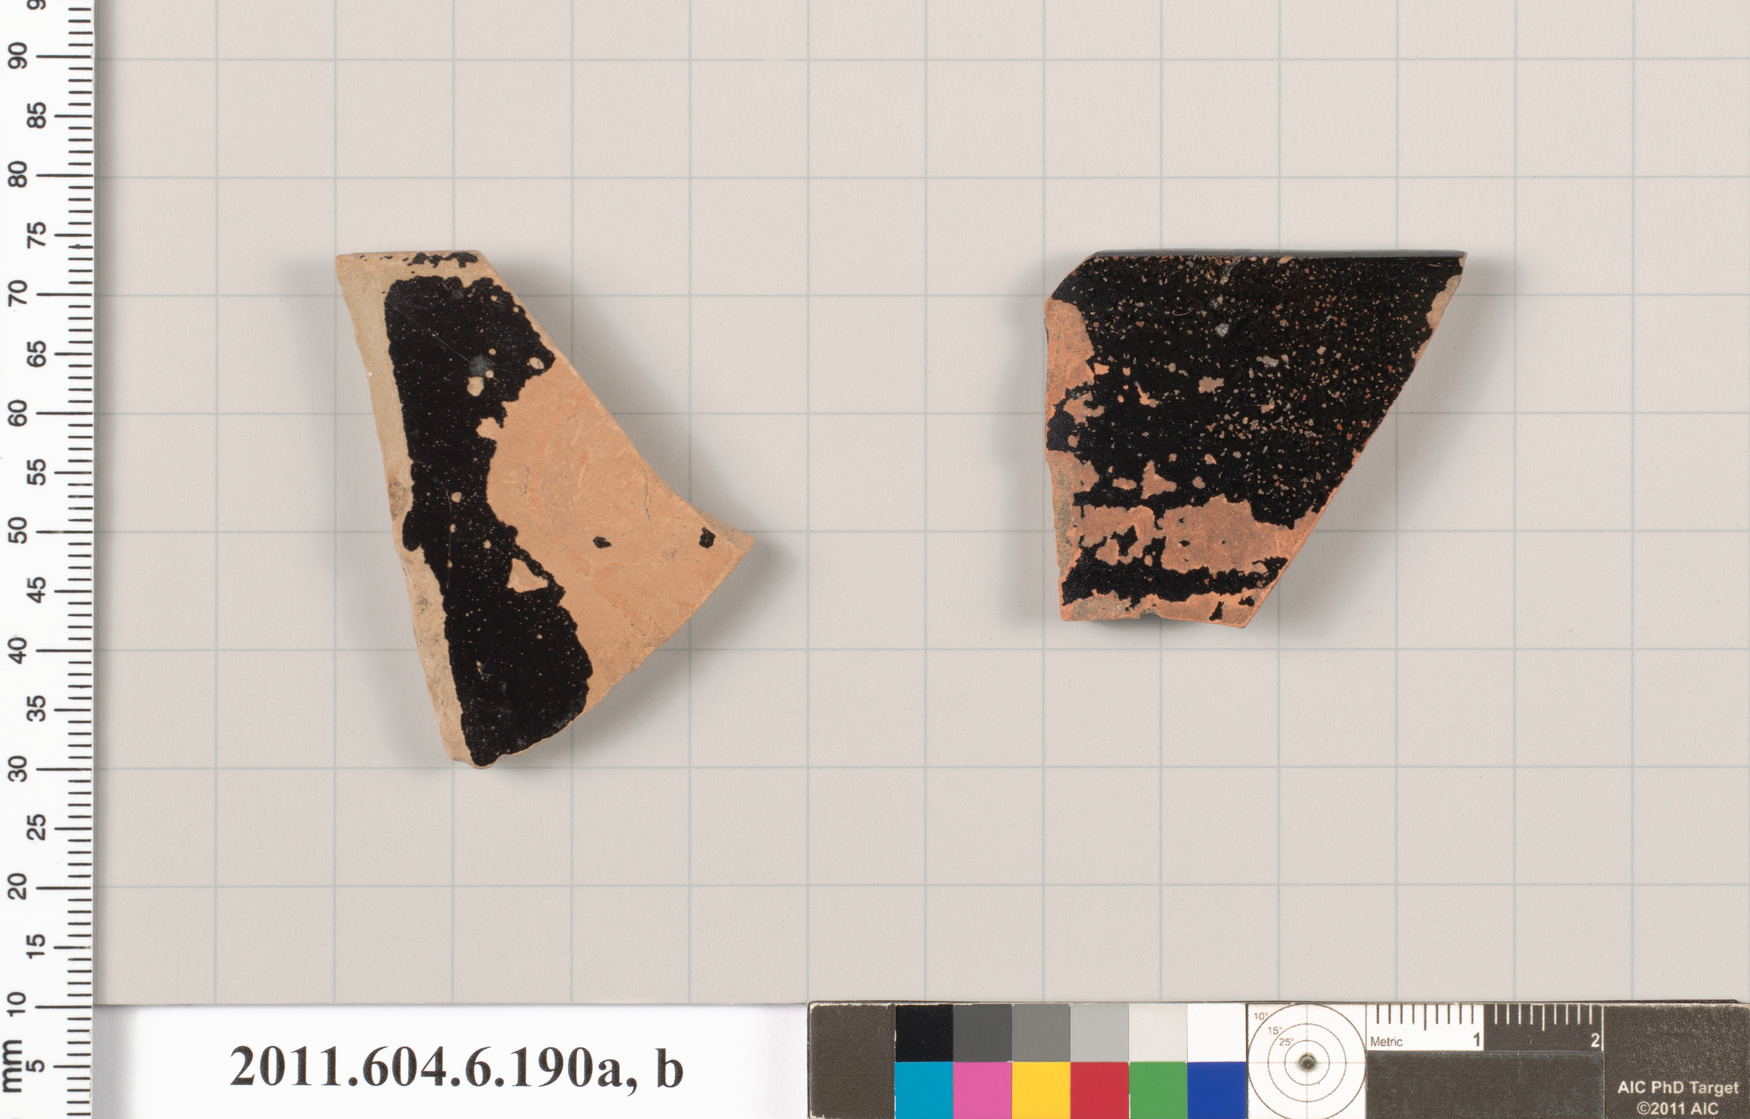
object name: skyphos fragment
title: Terracotta rim fragments of skyphoi (deep drinking cups)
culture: greek, attic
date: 500-401 BCE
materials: terracotta